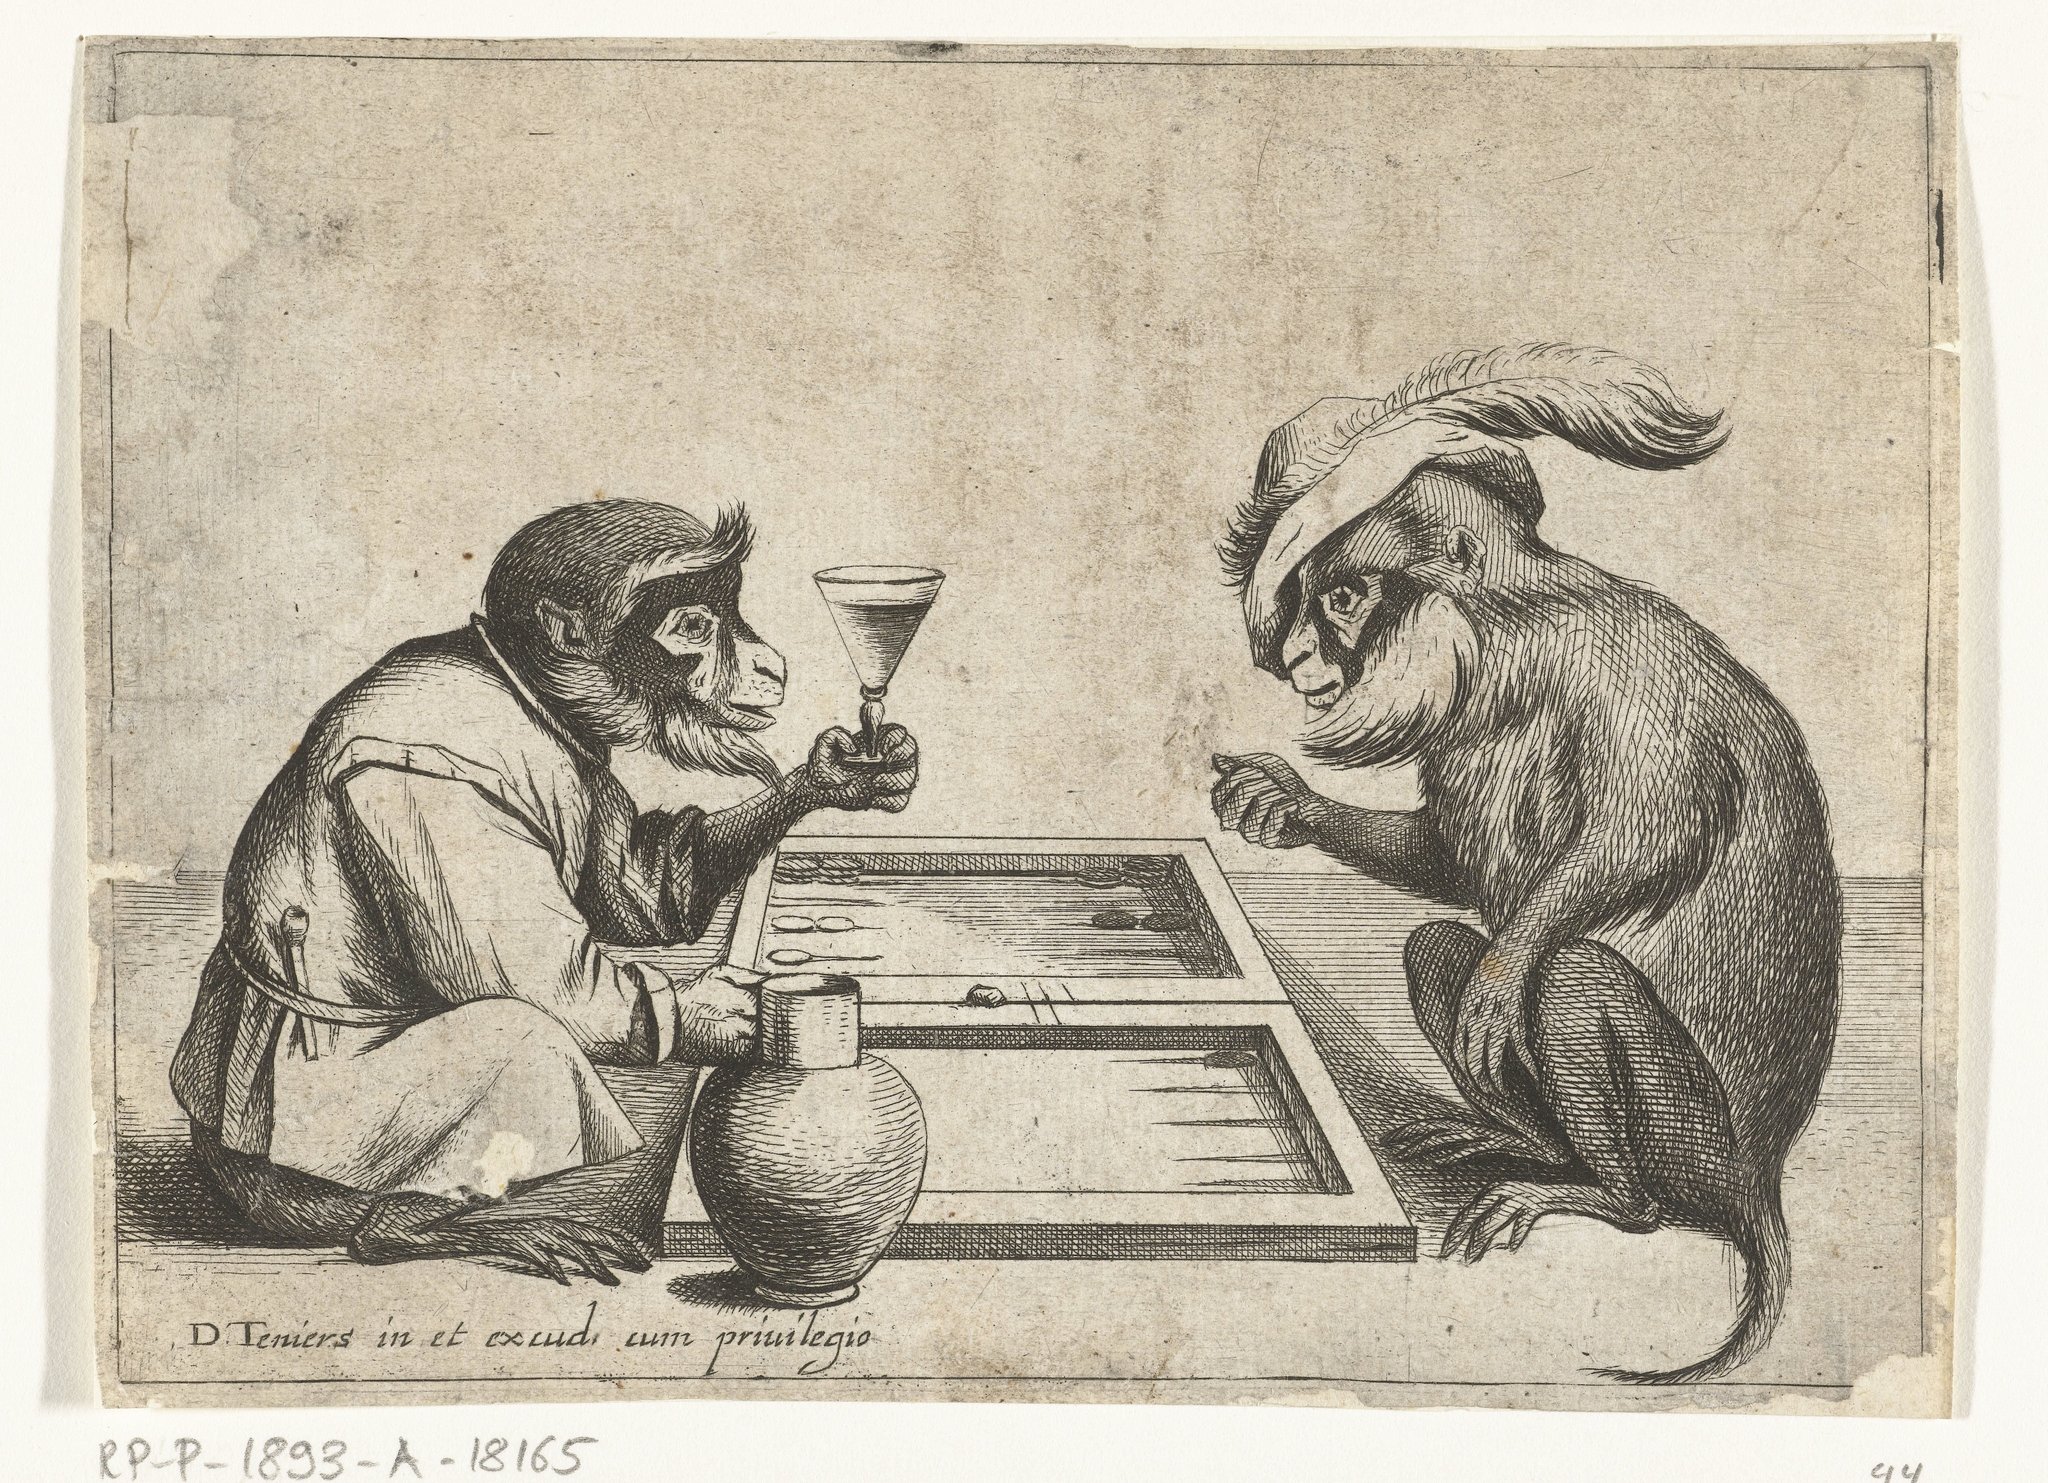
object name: print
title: Verschillende bedrijven uit het menselijke leven door apen voorgesteld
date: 1635-1690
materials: paper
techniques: etching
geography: southern netherlands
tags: animals acting as human beings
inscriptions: collector's mark: Lugt 2228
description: Twee apen zitten op de grond naast een triktrak spel. De rechte draagt een hoed met een hanenveer, de linke drinkt wijn uit een glas. Prent uit een serie van zes prenten en een titelprent waarin verschillende menselijke bezigheden door apen voorgesteld worden.